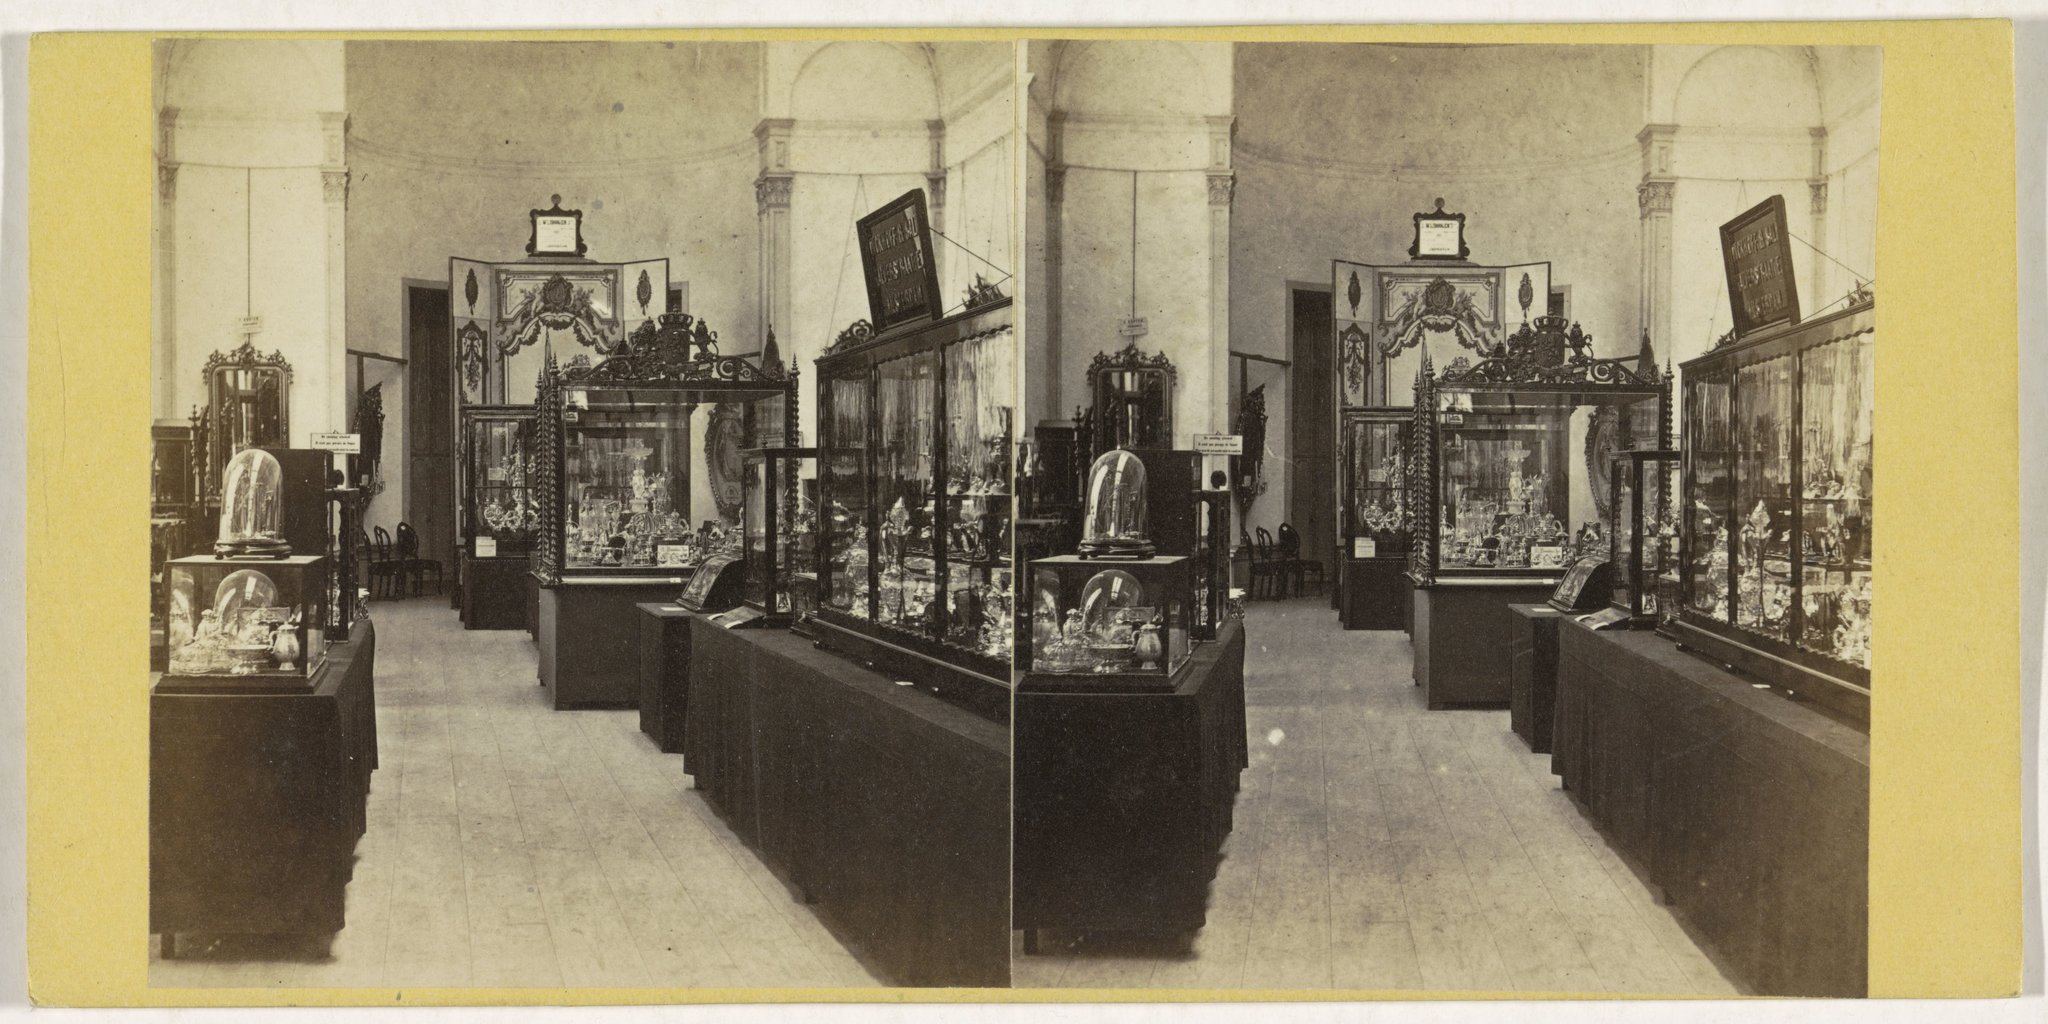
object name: stereograph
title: Vitrinekasten met objecten bij de Tentoonstelling voor Nationale Nijverheid en Kunst in het Paleis voor Volksvlijt, Amsterdam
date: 1866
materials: cardboard, paper, photographic support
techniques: albumen print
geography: amsterdam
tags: amsterdam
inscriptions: label: ‘Boek & Kunsthandel Jan D. Brouwer, Kalverstraat E, Nº 37 Amsterdam.’, stamp: ‘JDB’